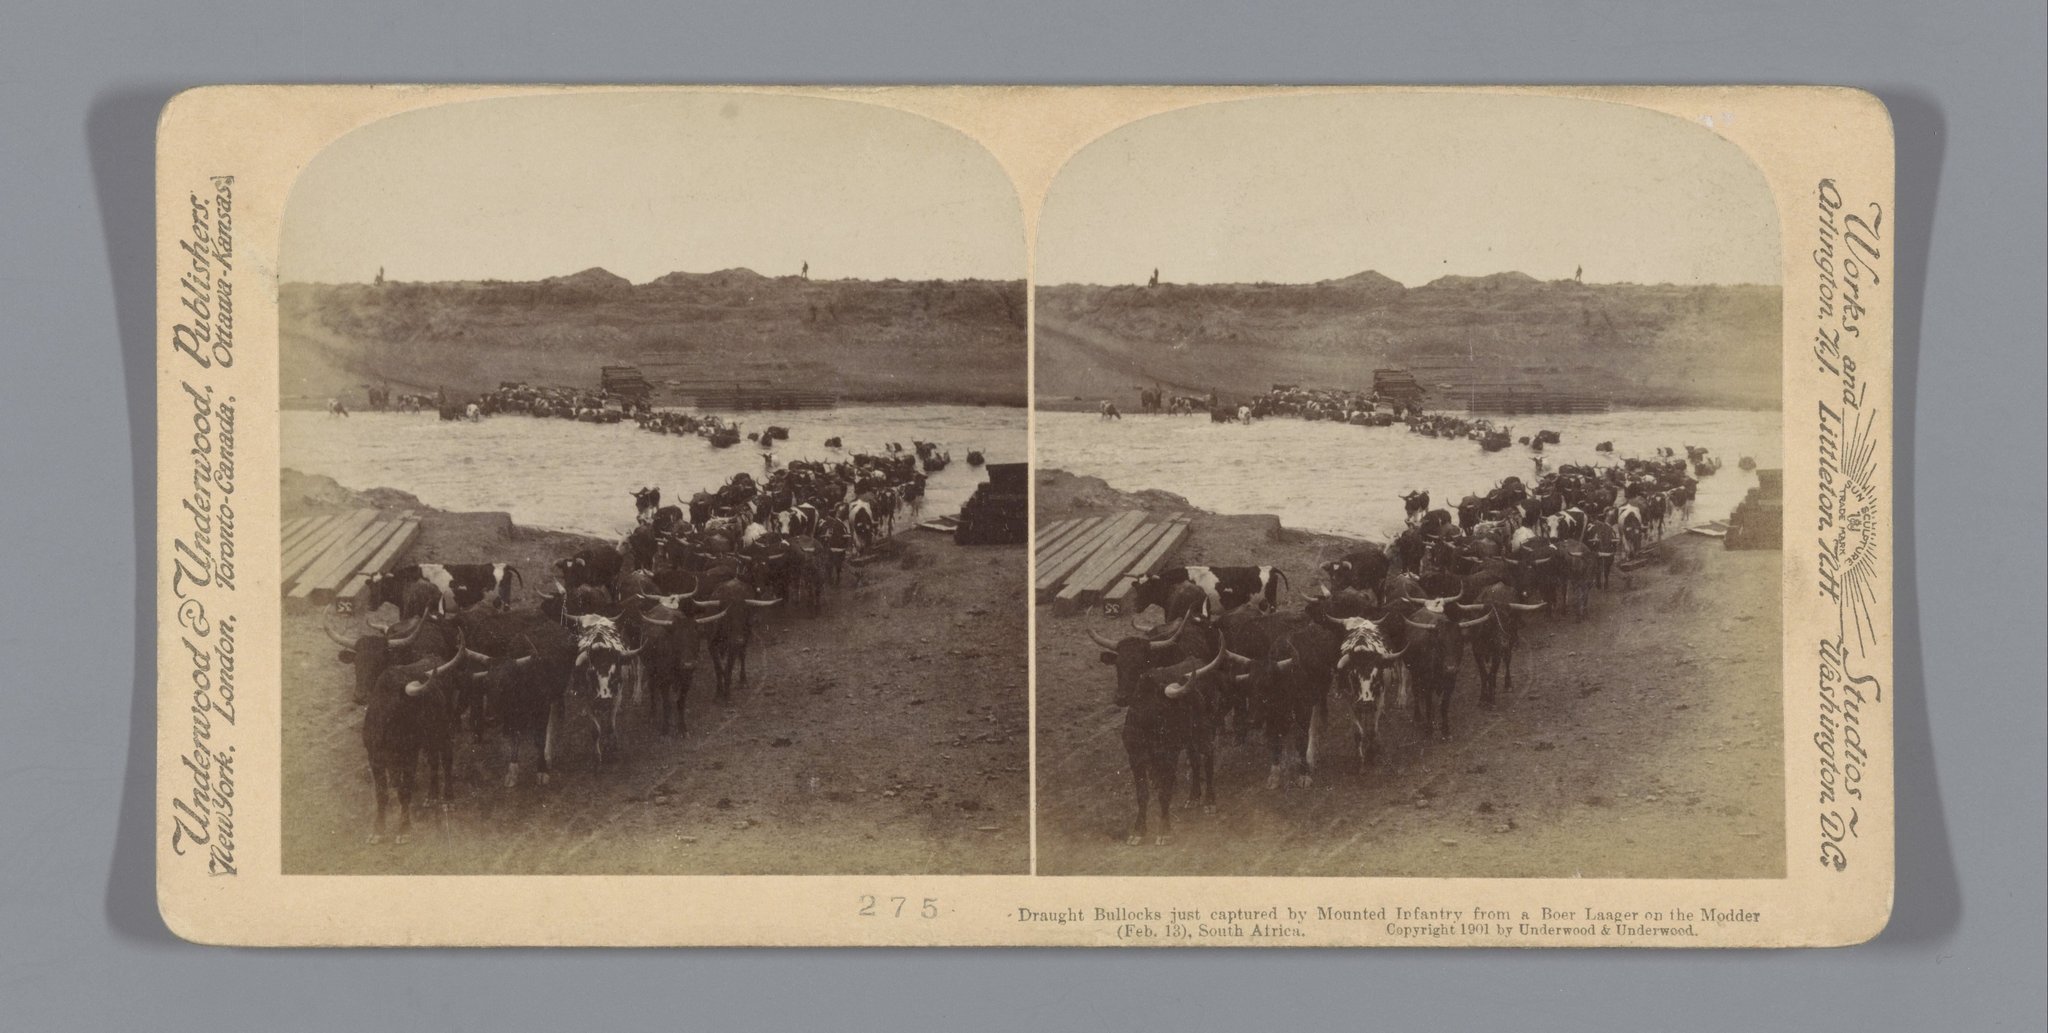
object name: stereograph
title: Draught Bullocks just captured by Mounted Infantry from a Boer Laager on the Modder (Feb. 13), South Africa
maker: Anonymous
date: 1901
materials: cardboard, paper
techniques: albumen print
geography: new york city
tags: ox, herd, flock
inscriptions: inscription: ‘Works and Studios ~/ Arlington, N.J. Littleton, N.H. Washington, D.C.’, number: ‘275’, inscription: ‘Draught Bullocks just captured by Mounted Infantry from a Boer Laager on the Modder (Feb. 19), S. Africa.’, copyright notice: ‘Copyright 1901 by Underwood & Underwood.’